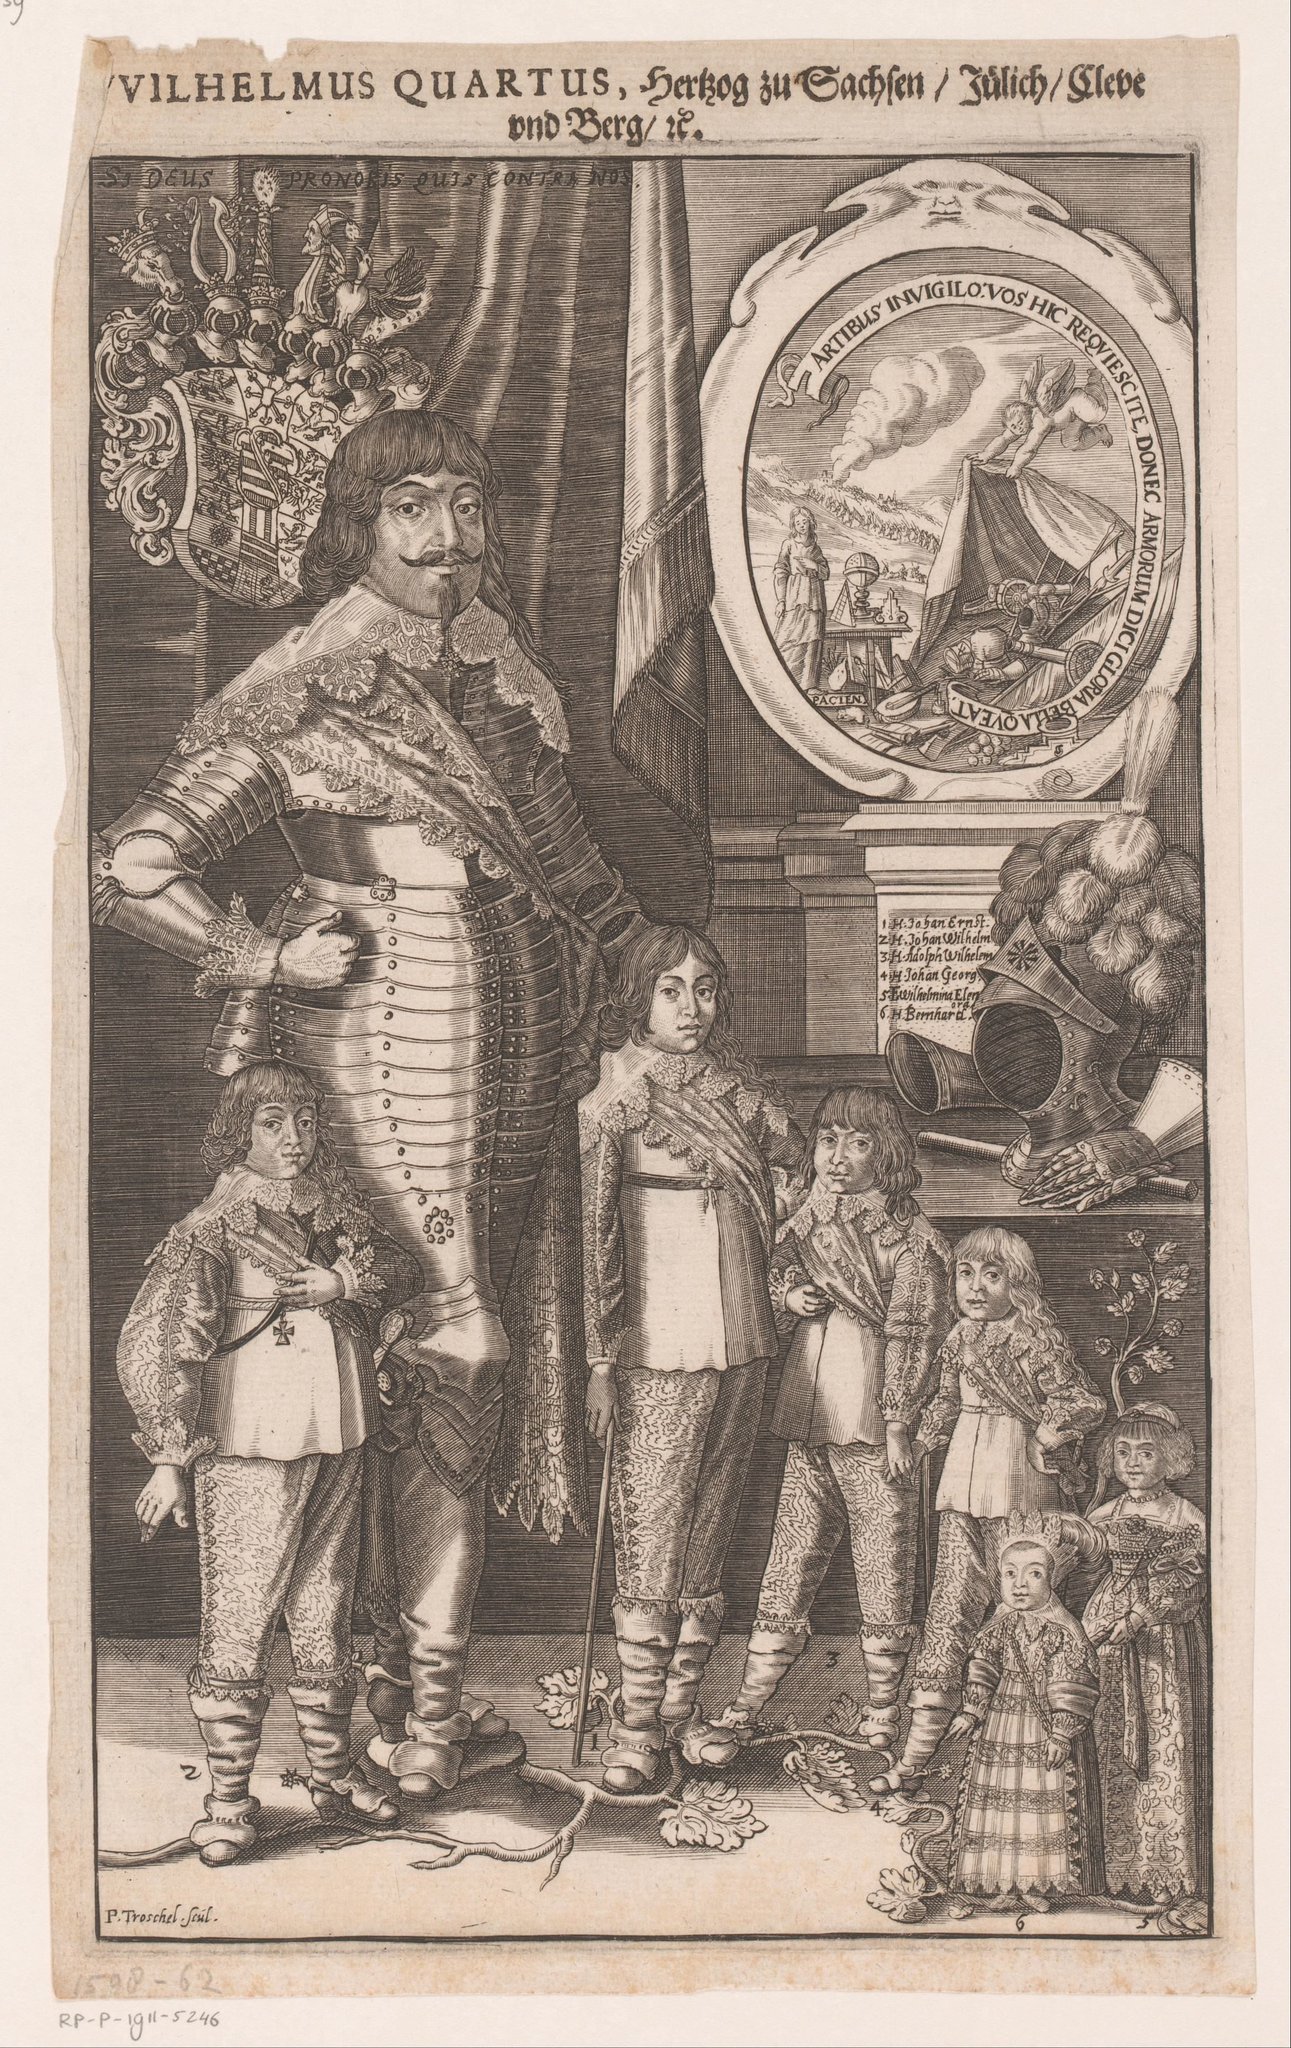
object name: print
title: Portret van Wilhelm von Sachsen-Weimar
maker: peter troschel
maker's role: draughtsman, print maker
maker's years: 1620-1670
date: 1645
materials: paper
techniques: engraving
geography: germany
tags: helmet, armour, historical persons, armorial bearing, heraldry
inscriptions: collector's mark: Lugt 2228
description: Prent gebruikt voor de publicatie: Hortleder, Friedrich. Der Römischen Kaiser- und Königlichen Majestäten. Gotha: Wolfgang Endter, 1645.